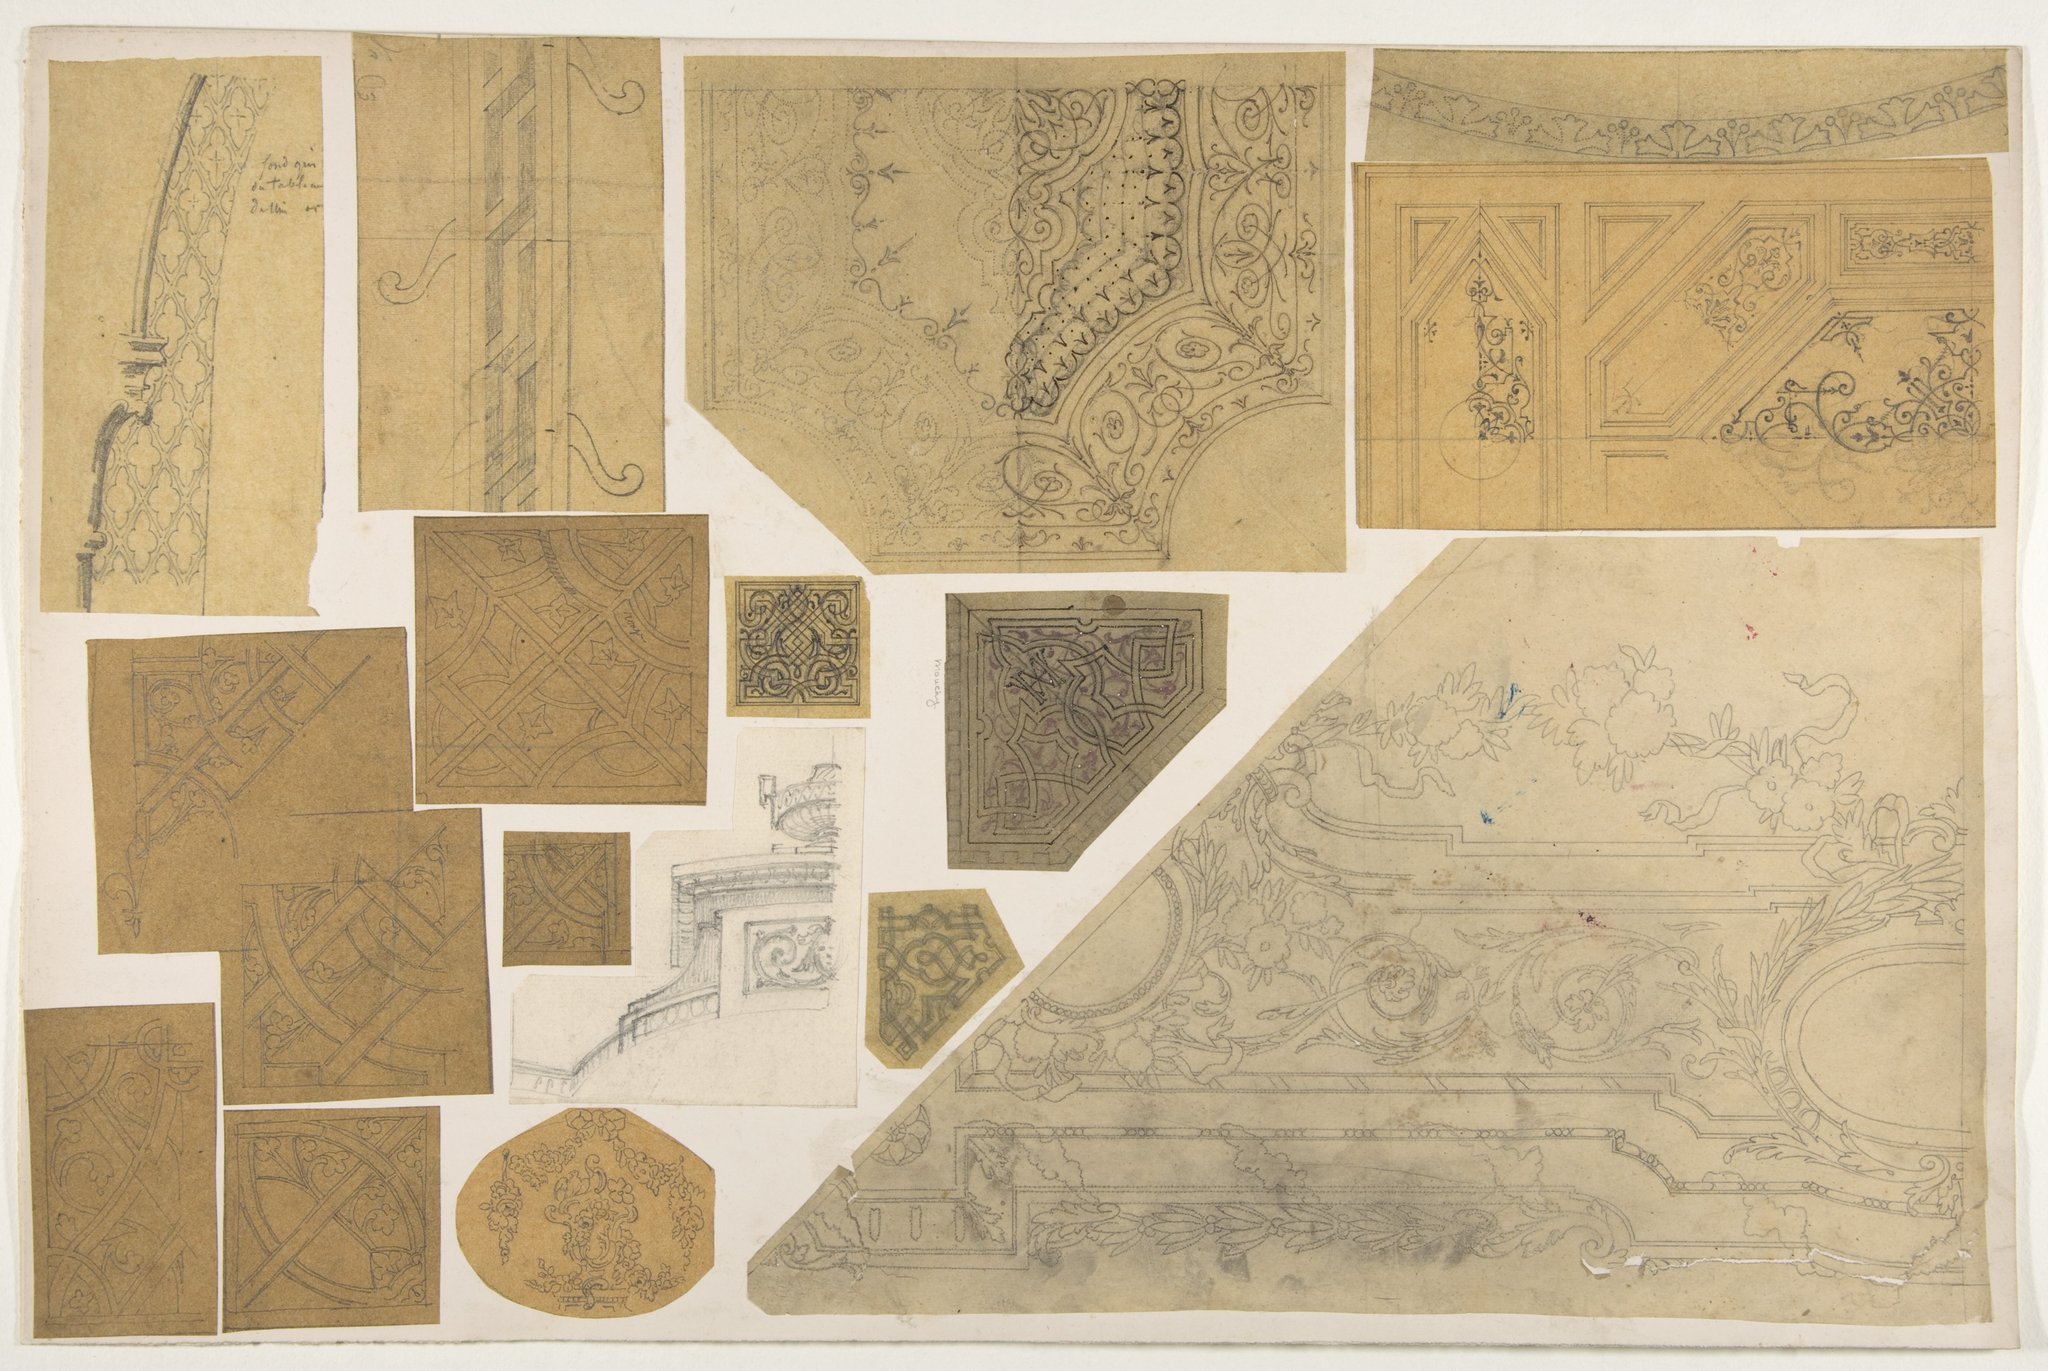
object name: drawing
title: Sixteen designs of the decoration of walls and ceilings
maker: jules-edmond-charles lachaise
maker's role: artist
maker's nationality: french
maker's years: 1897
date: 1851-1900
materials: graphite, ink, paper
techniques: pen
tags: flowers,leaves